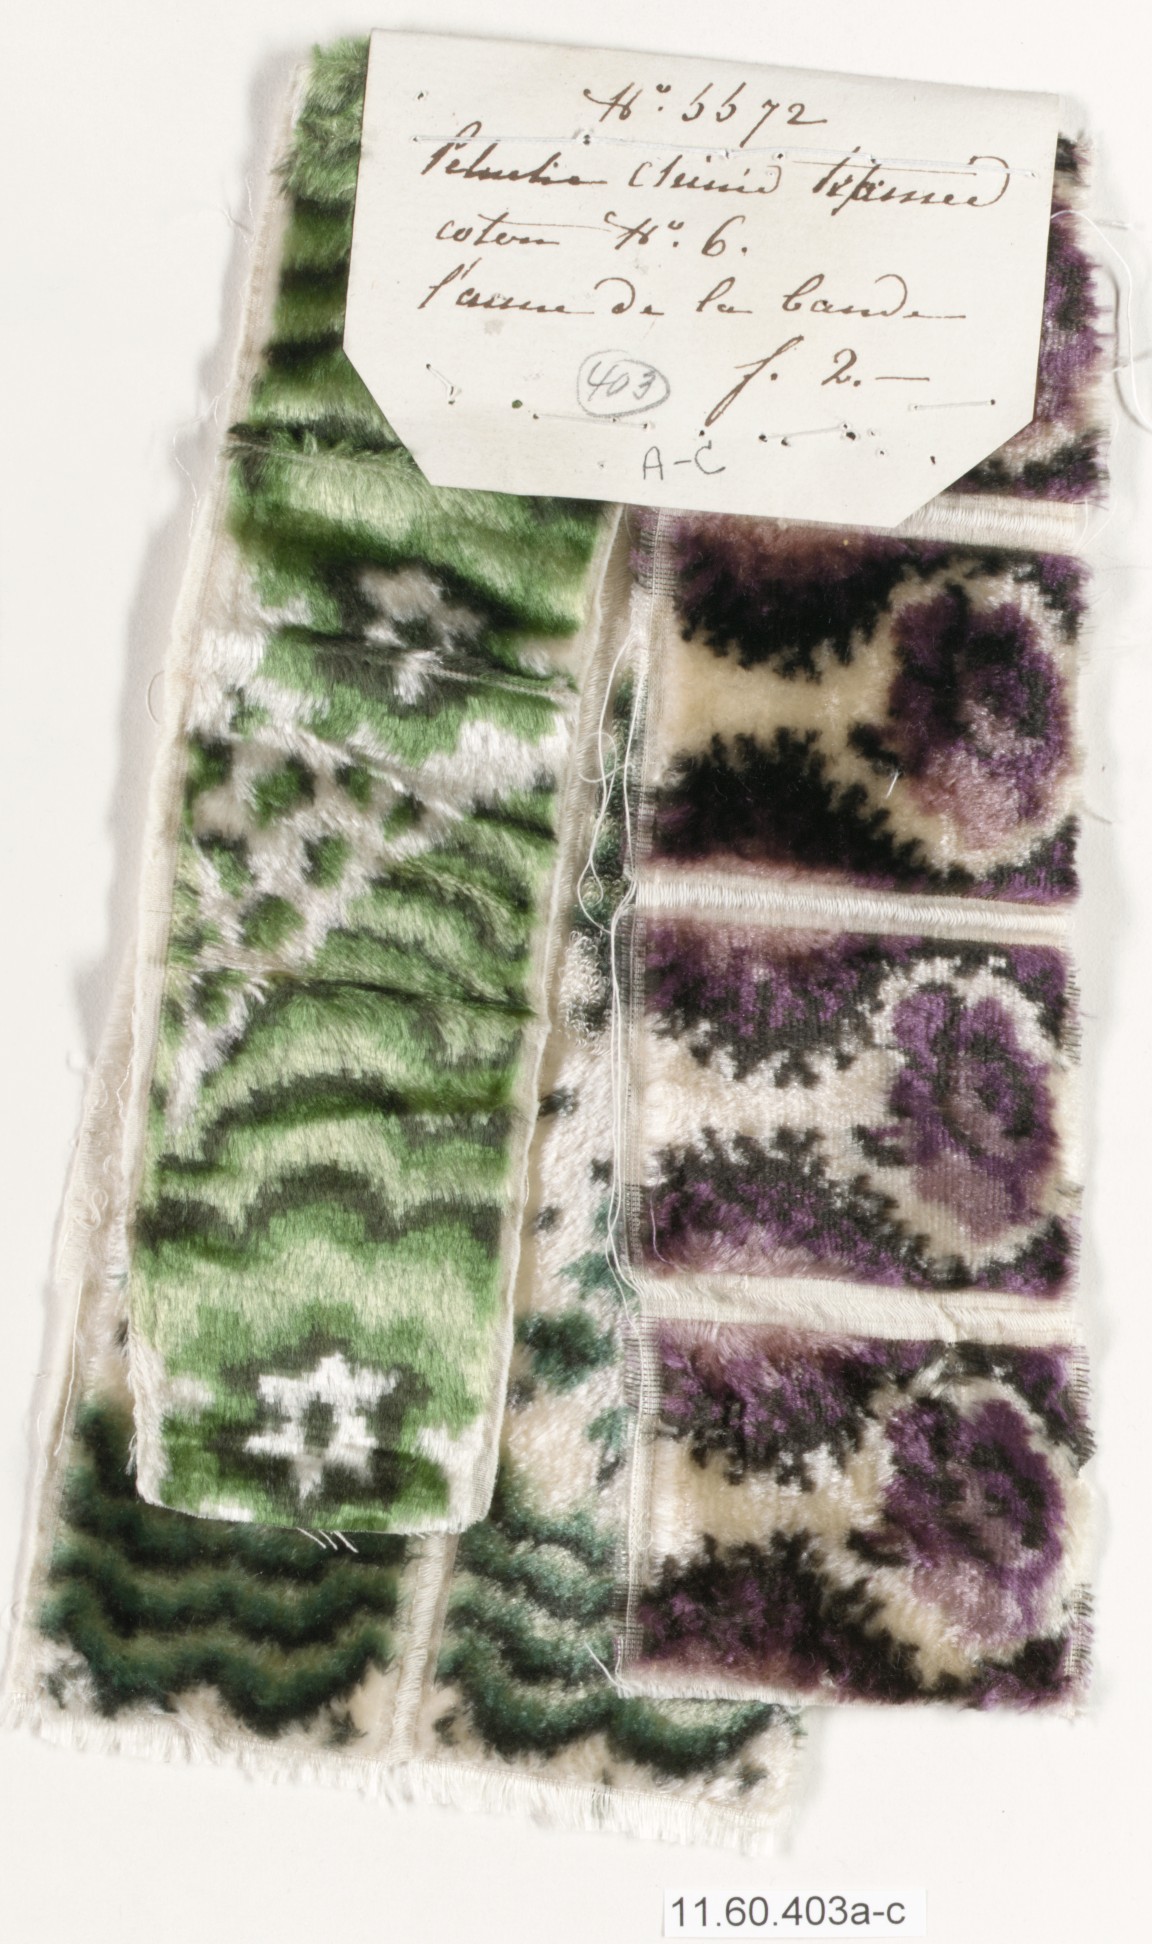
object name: fragment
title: Fragments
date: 1801-1900